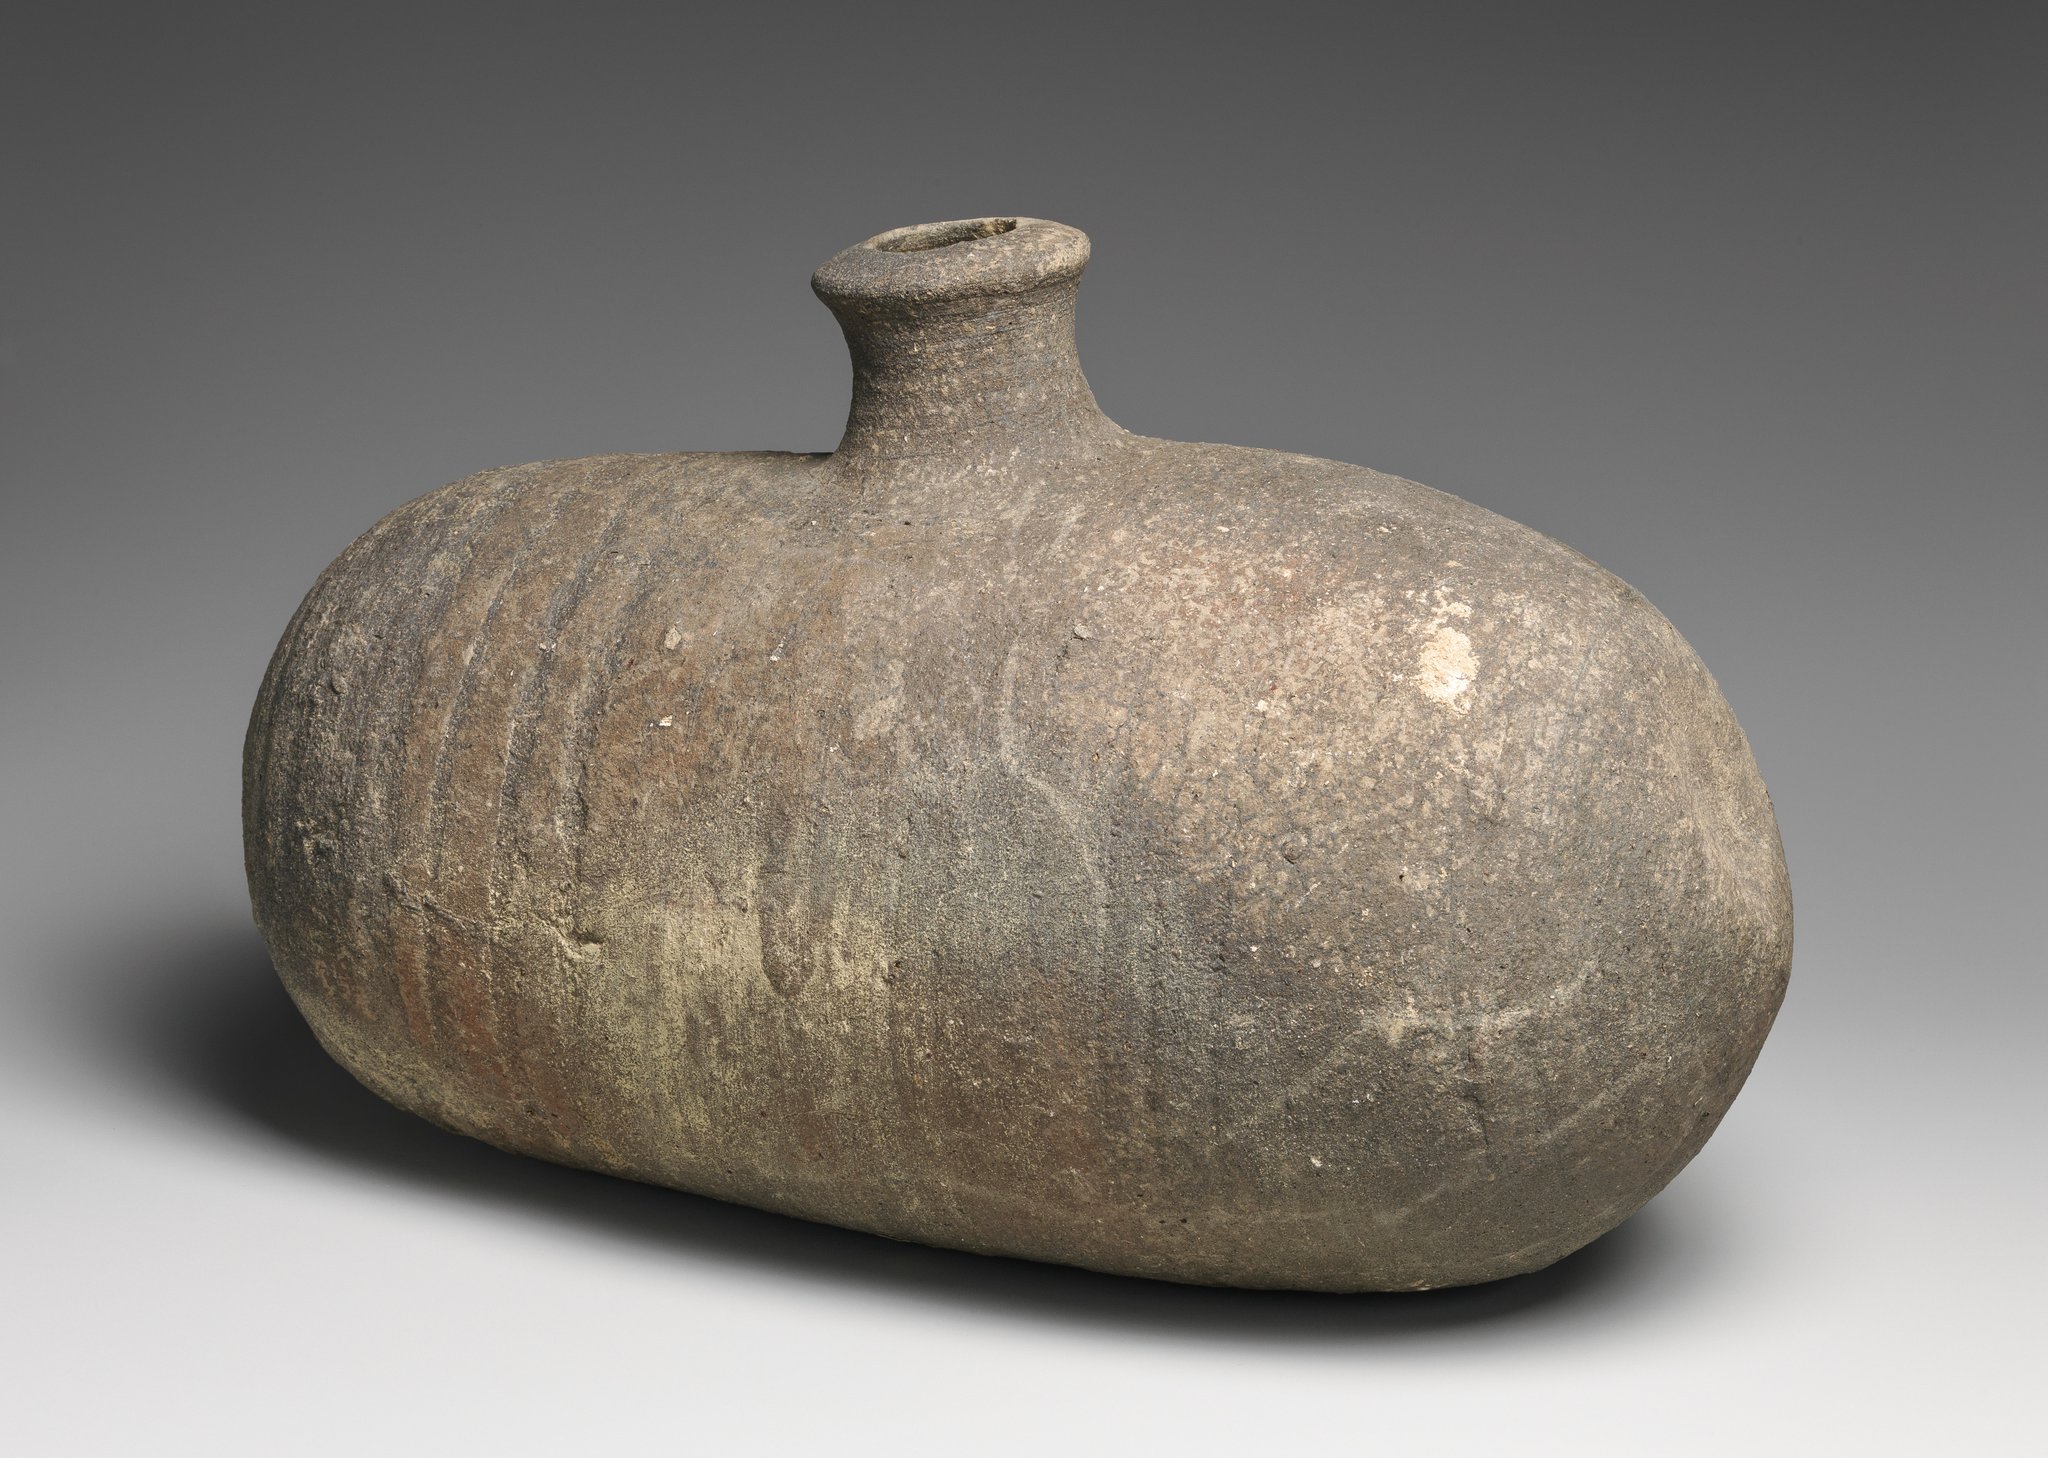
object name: jug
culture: coptic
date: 400 BCE-400 CE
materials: earthenware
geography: egypt